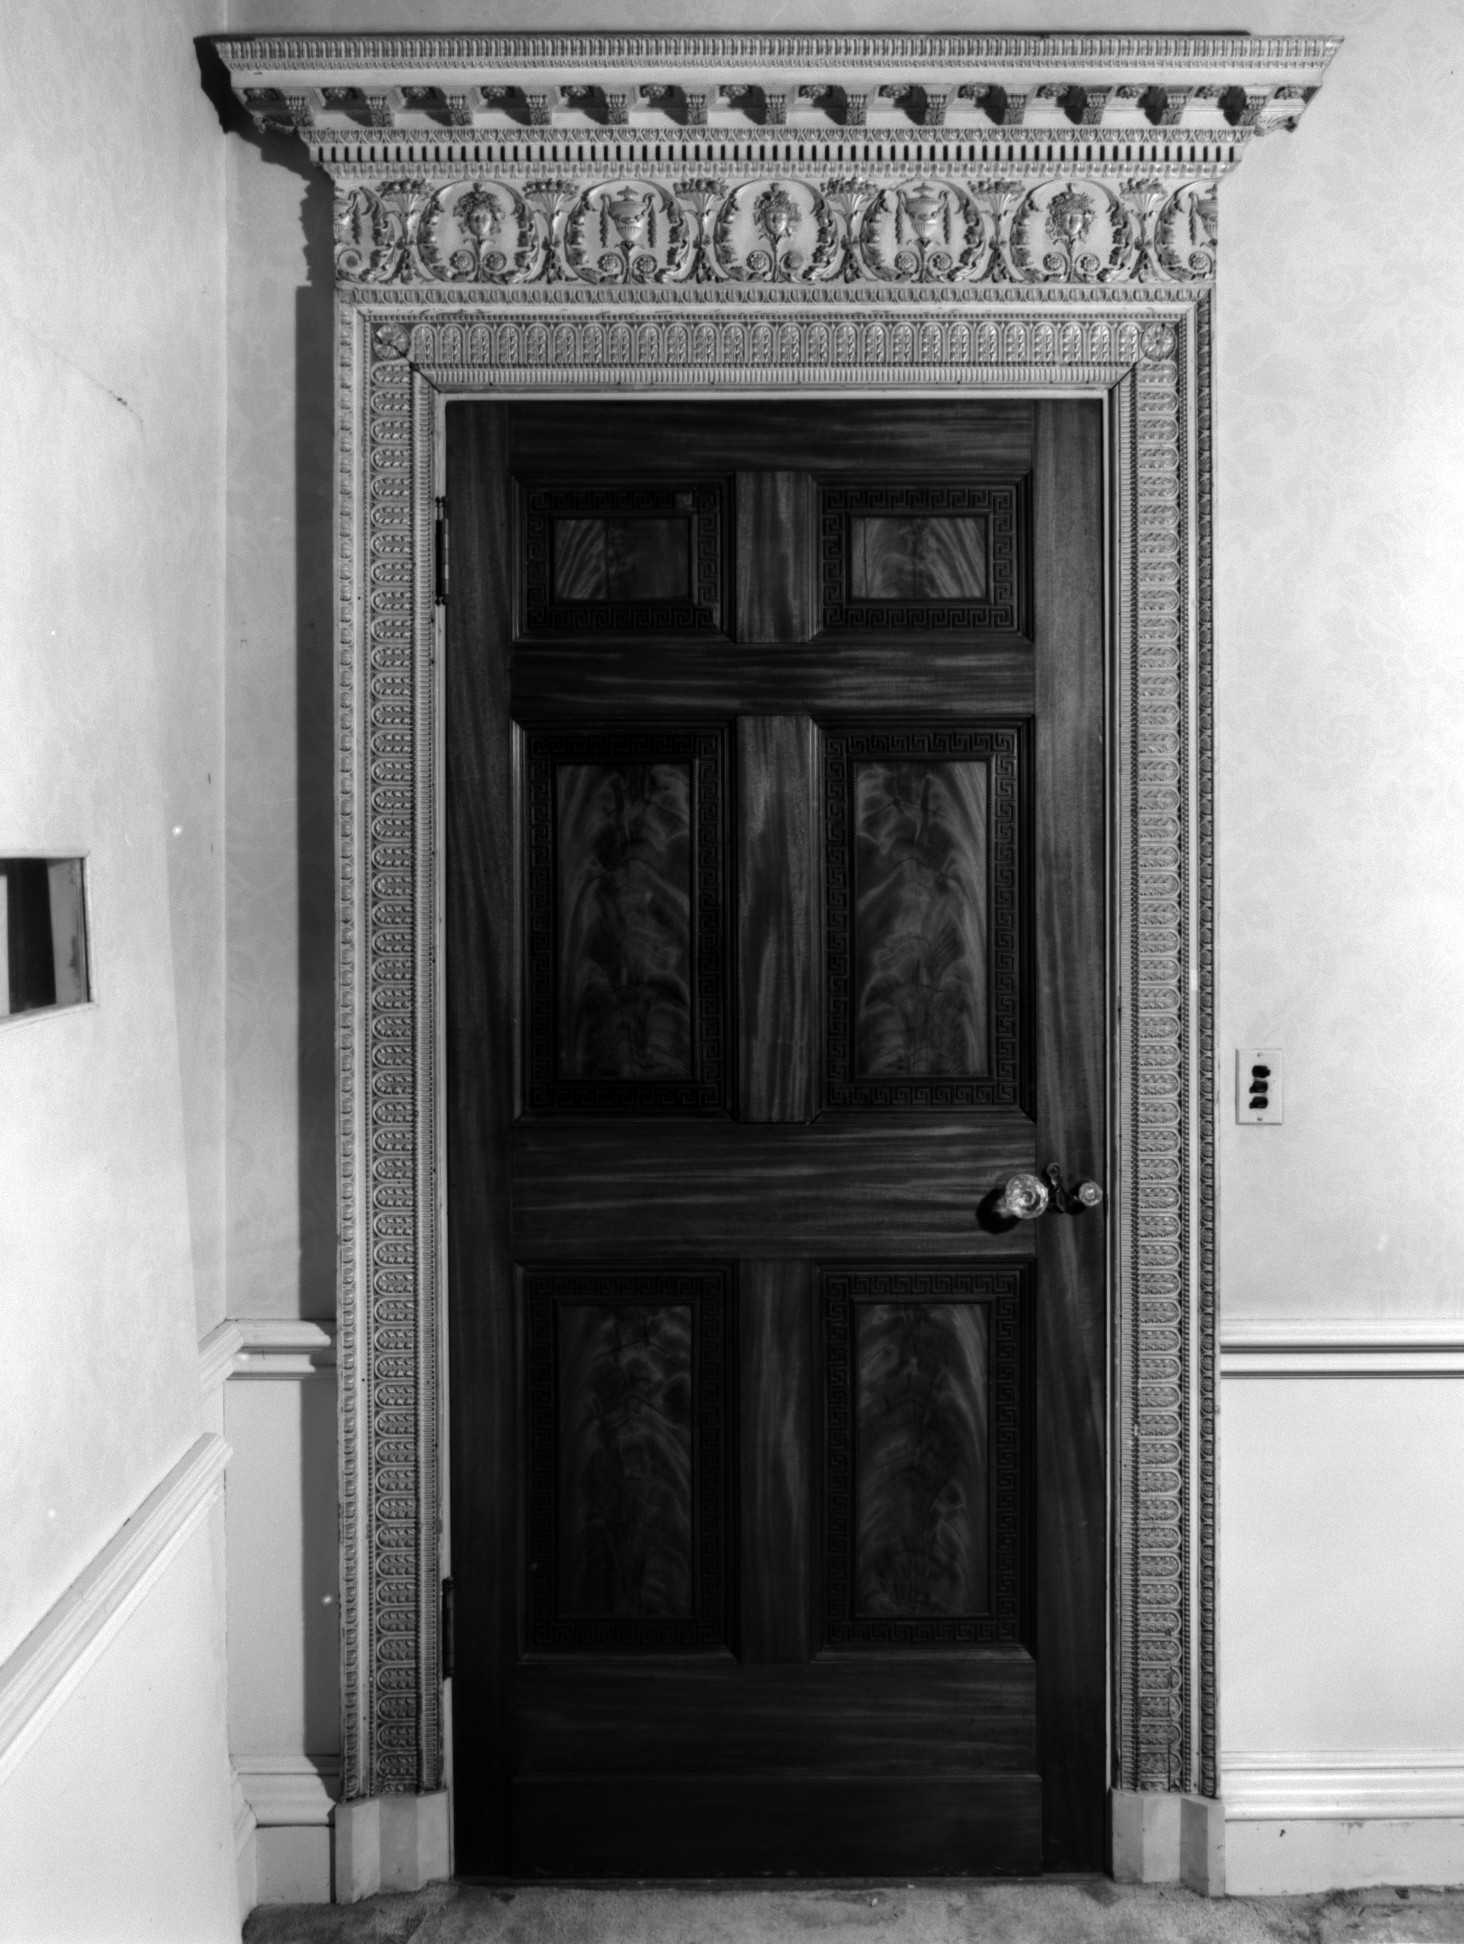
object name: doorway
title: Doorway (one of a pair)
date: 1776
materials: gilt, wood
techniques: painting